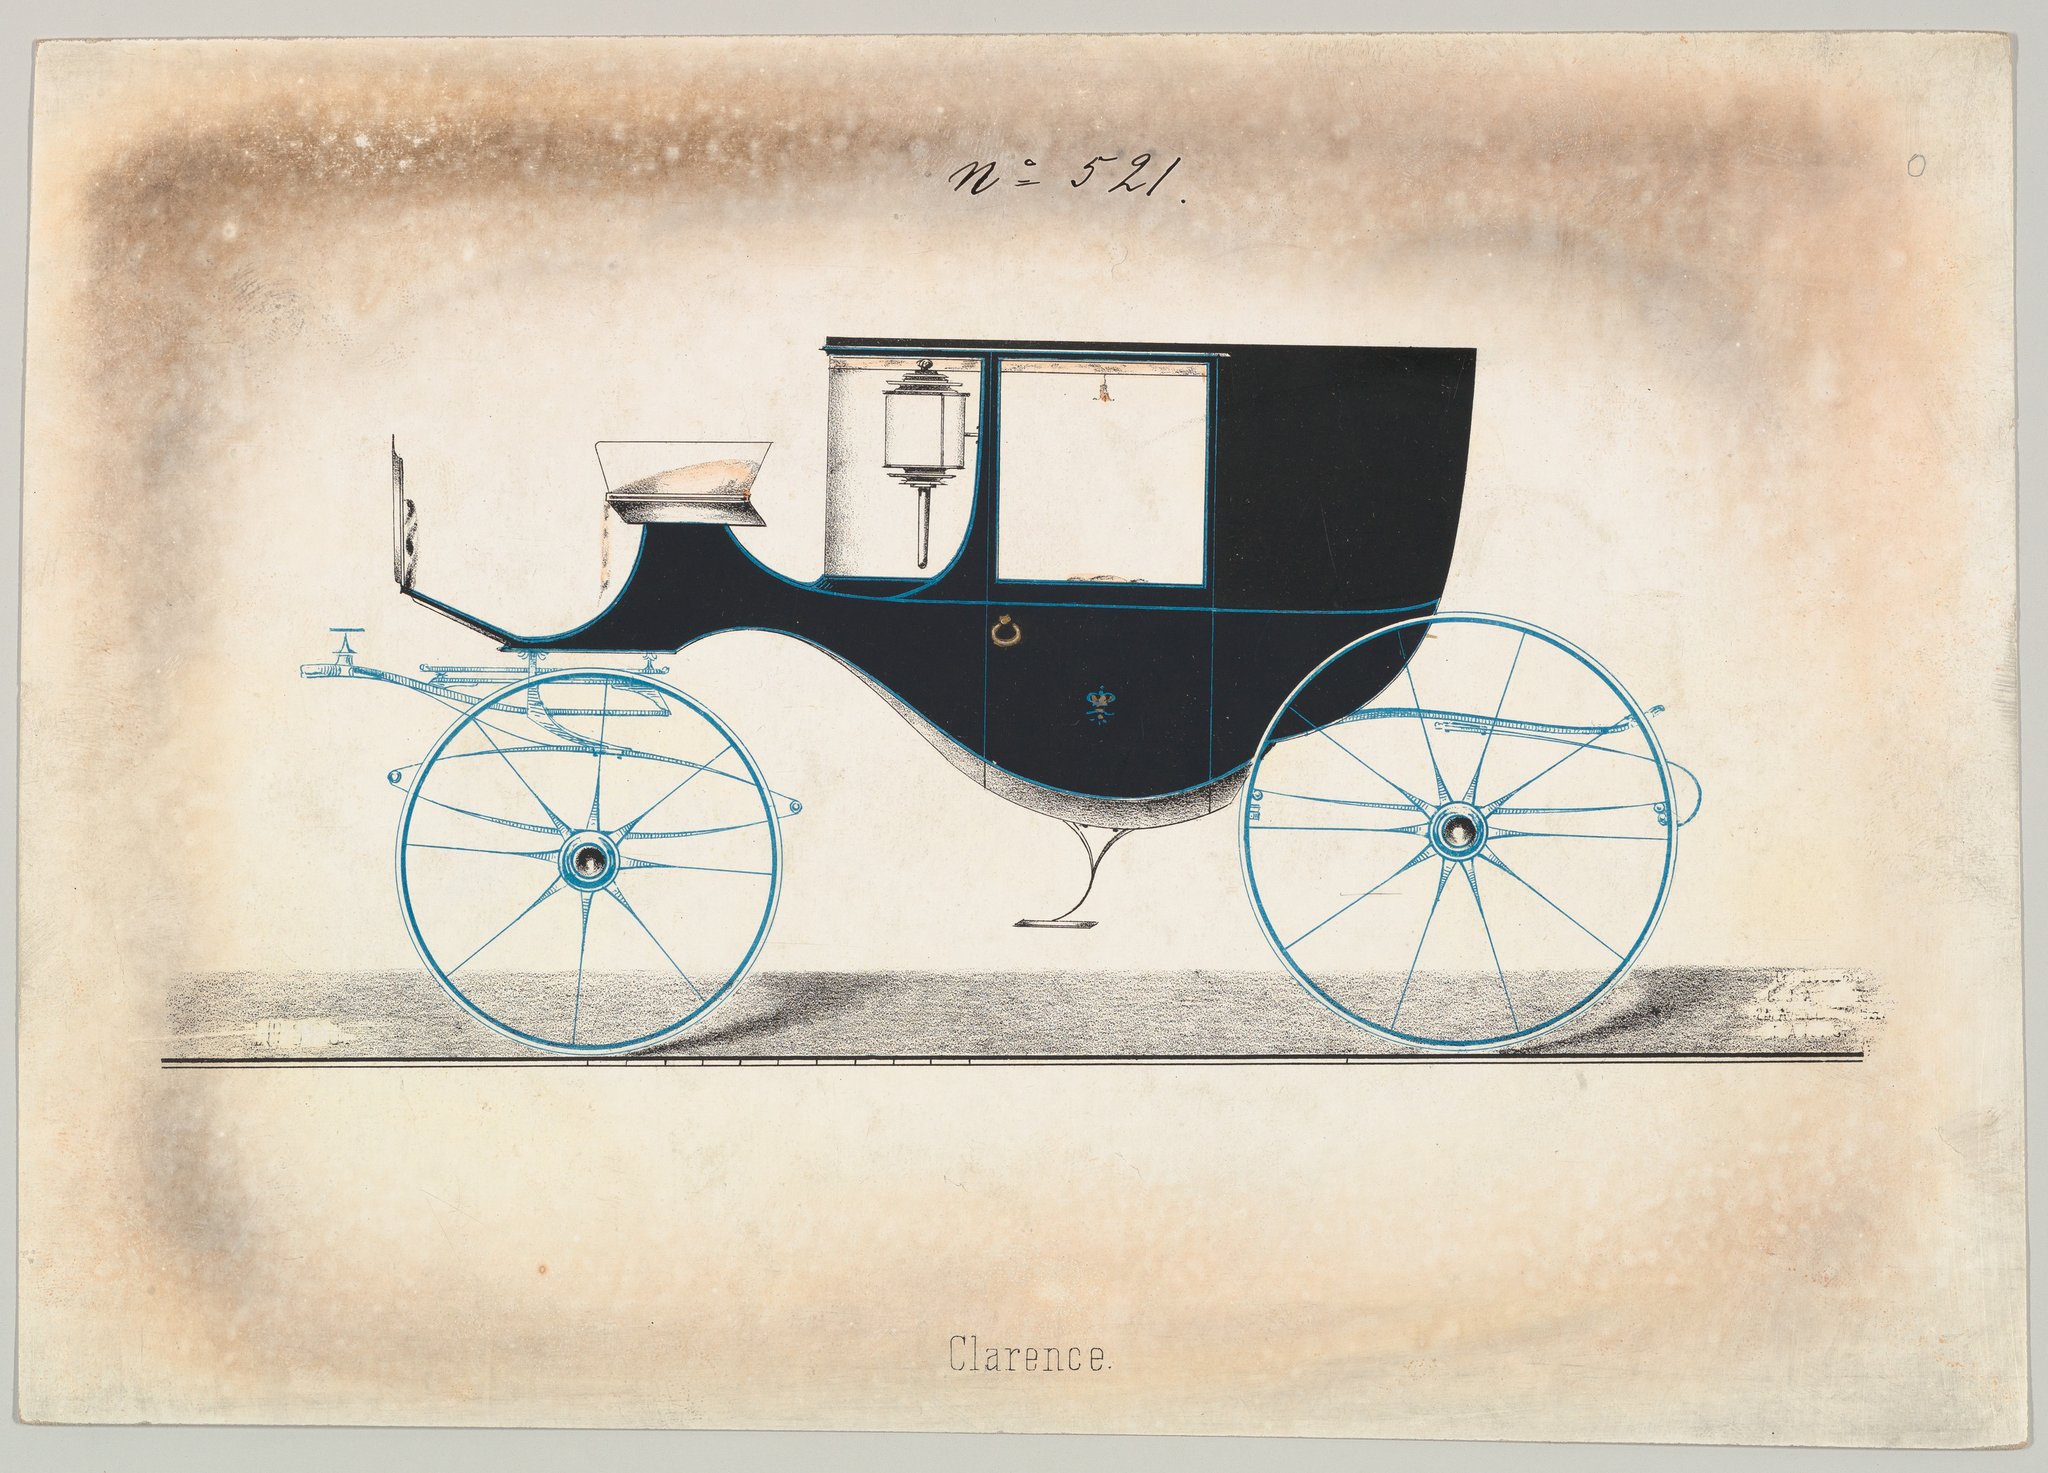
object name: drawing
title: Clarence #521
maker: brewster & co.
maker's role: manufacturer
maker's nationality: american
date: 1850-1870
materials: ink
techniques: hand coloring, lithograph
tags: carriages